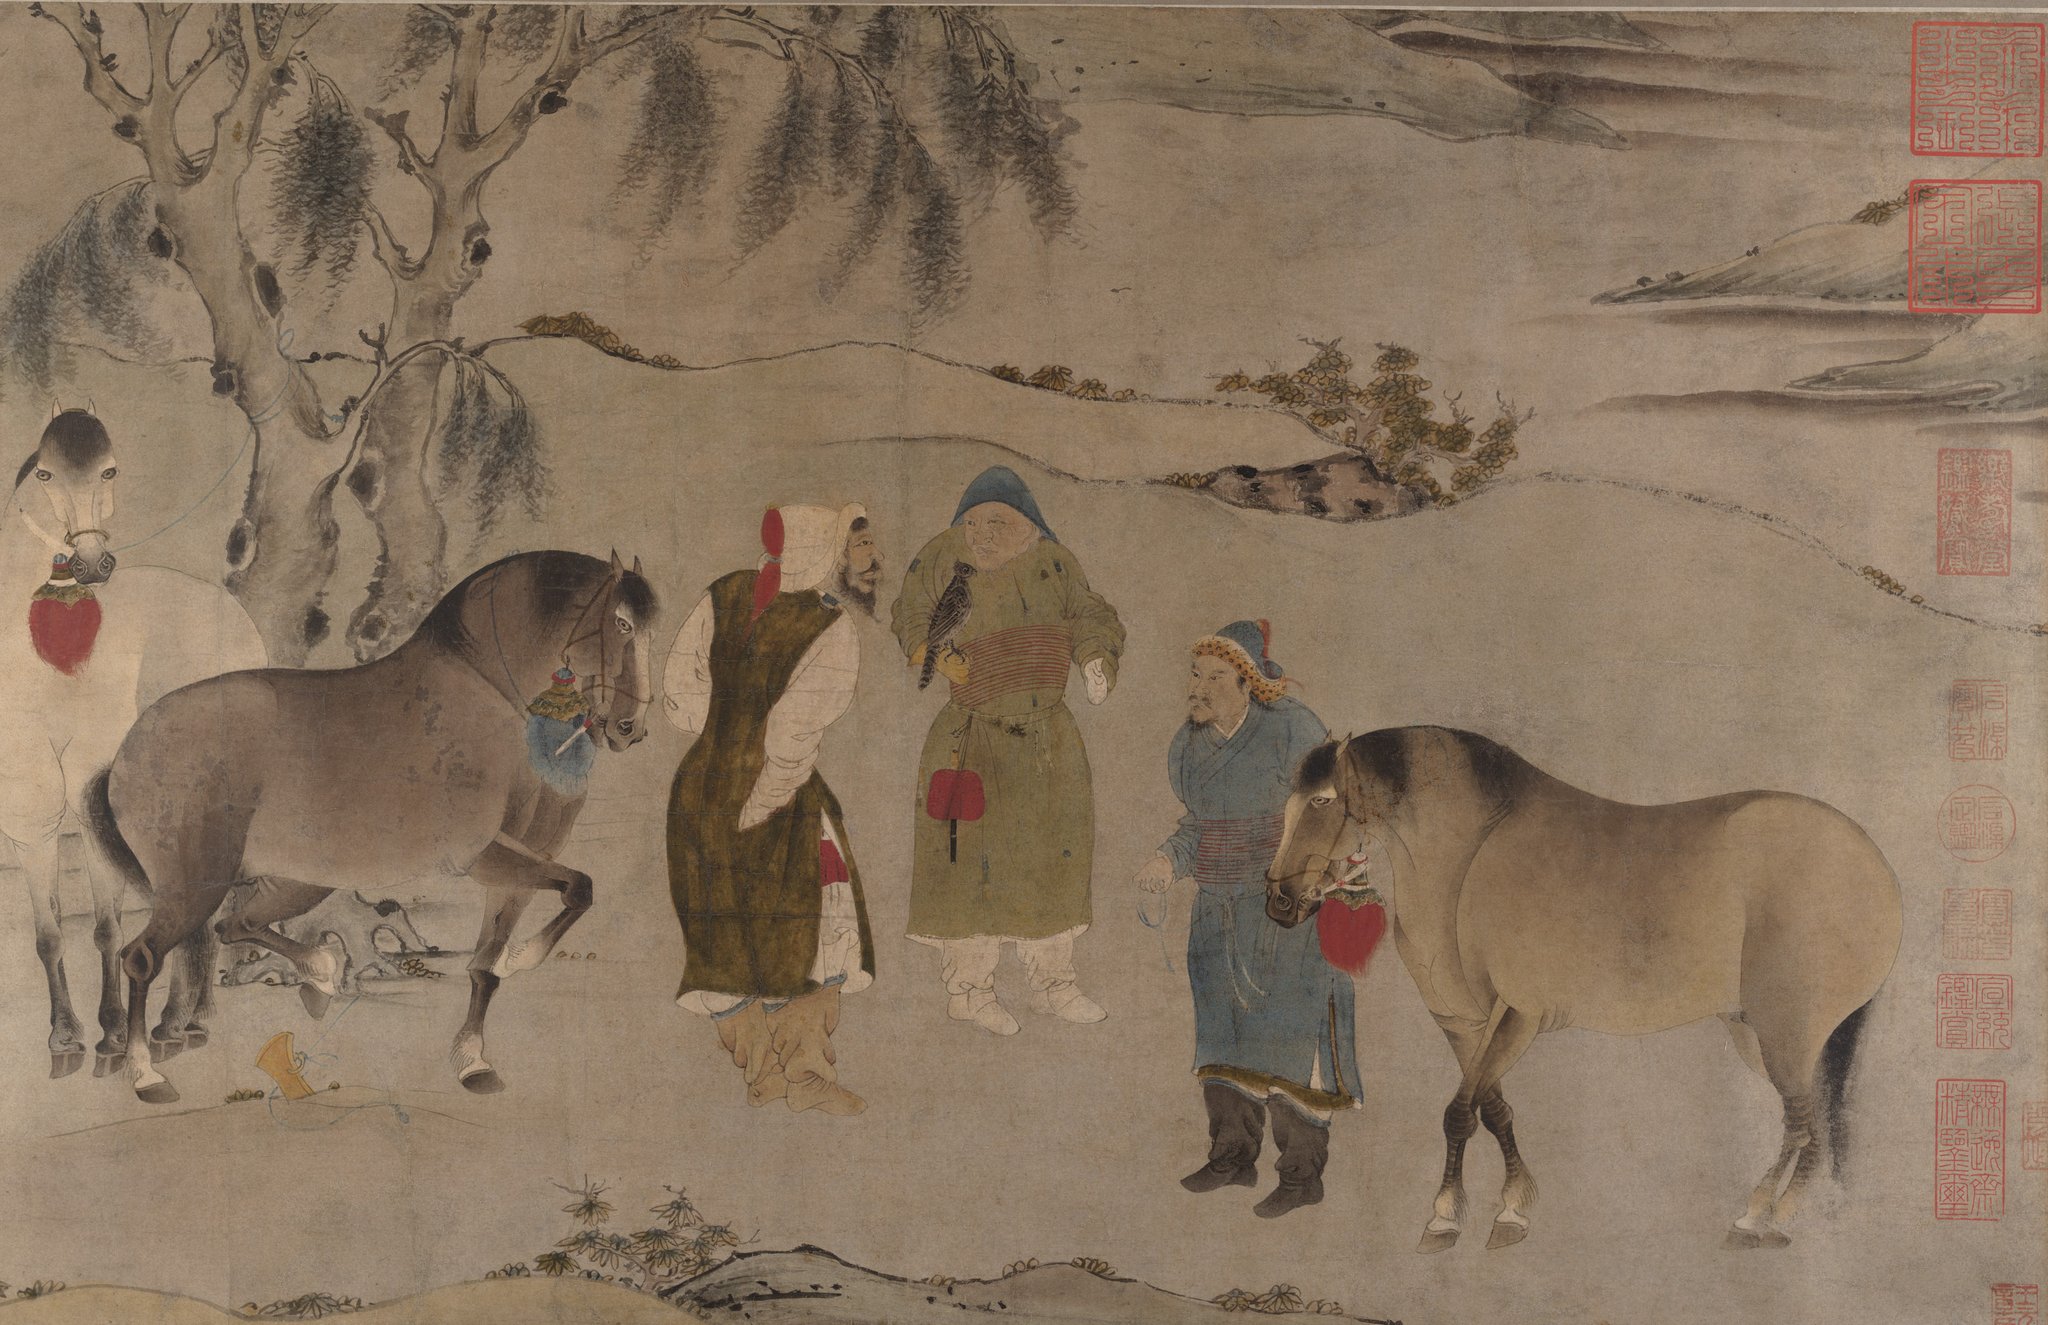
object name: handscroll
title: Six Horses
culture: chinese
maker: unidentified artists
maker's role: artist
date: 1201-1400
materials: ink, paper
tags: men,horses